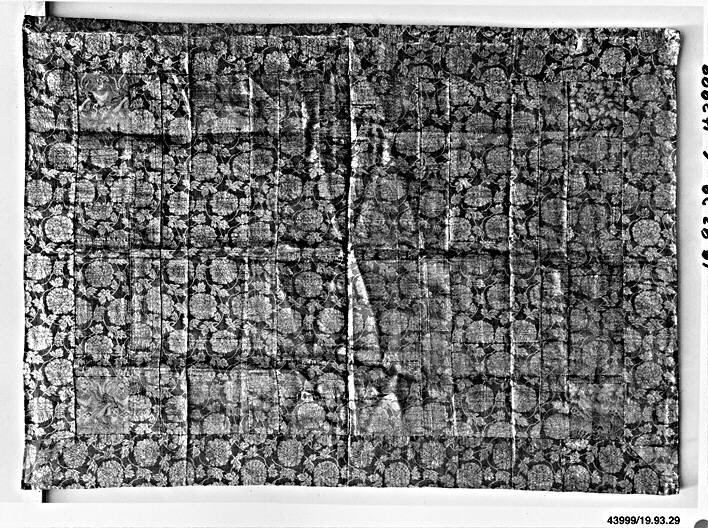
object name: robe, priest's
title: Priest's Robe (Shichijō)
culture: japanese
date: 1573-1592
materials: silk